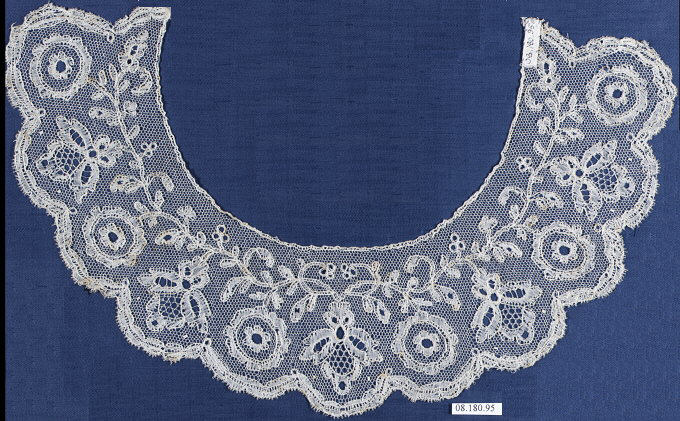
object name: collar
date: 1801-1900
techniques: lace